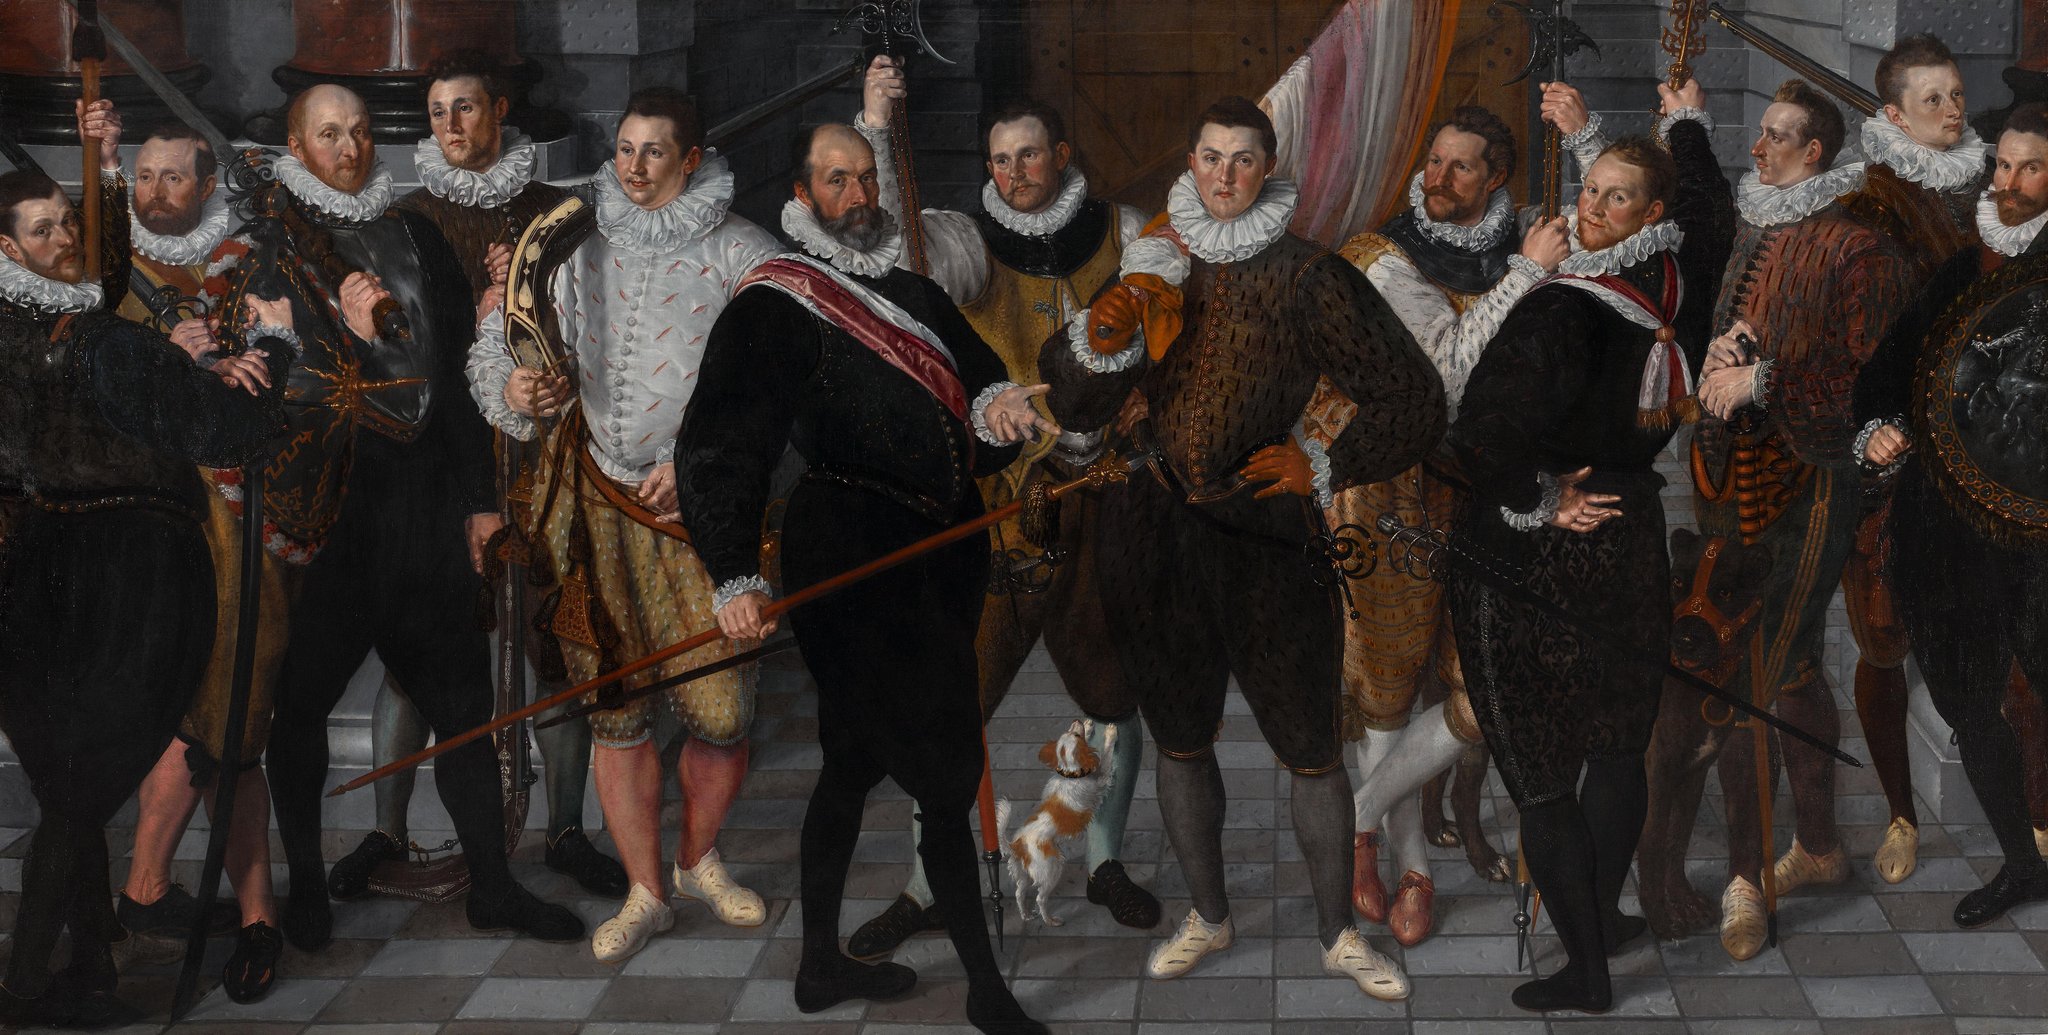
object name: painting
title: The Company of Captain Dirck Jacobsz Rosecrans and Lieutenant Pauw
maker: cornelis ketel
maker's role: draughtsman, painter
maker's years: 1548-1616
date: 1588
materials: canvas, oil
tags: warfare; military affairs (+ citizen soldiery, civil guard, citizen militia)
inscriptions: date: ‘.588’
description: Thirteen self-assured officers of the Amsterdam militia, the city’s armed civic guard, are portrayed here. From 1580, at the initiative of William of Orange, the old militia guilds were refashioned into civic guards organized along military lines. The officers were recruited from the upper levels of society. The dark muzzled dog at right contrasts comically with the jaunty little lapdog at centre jumping up on its owner’s legs.